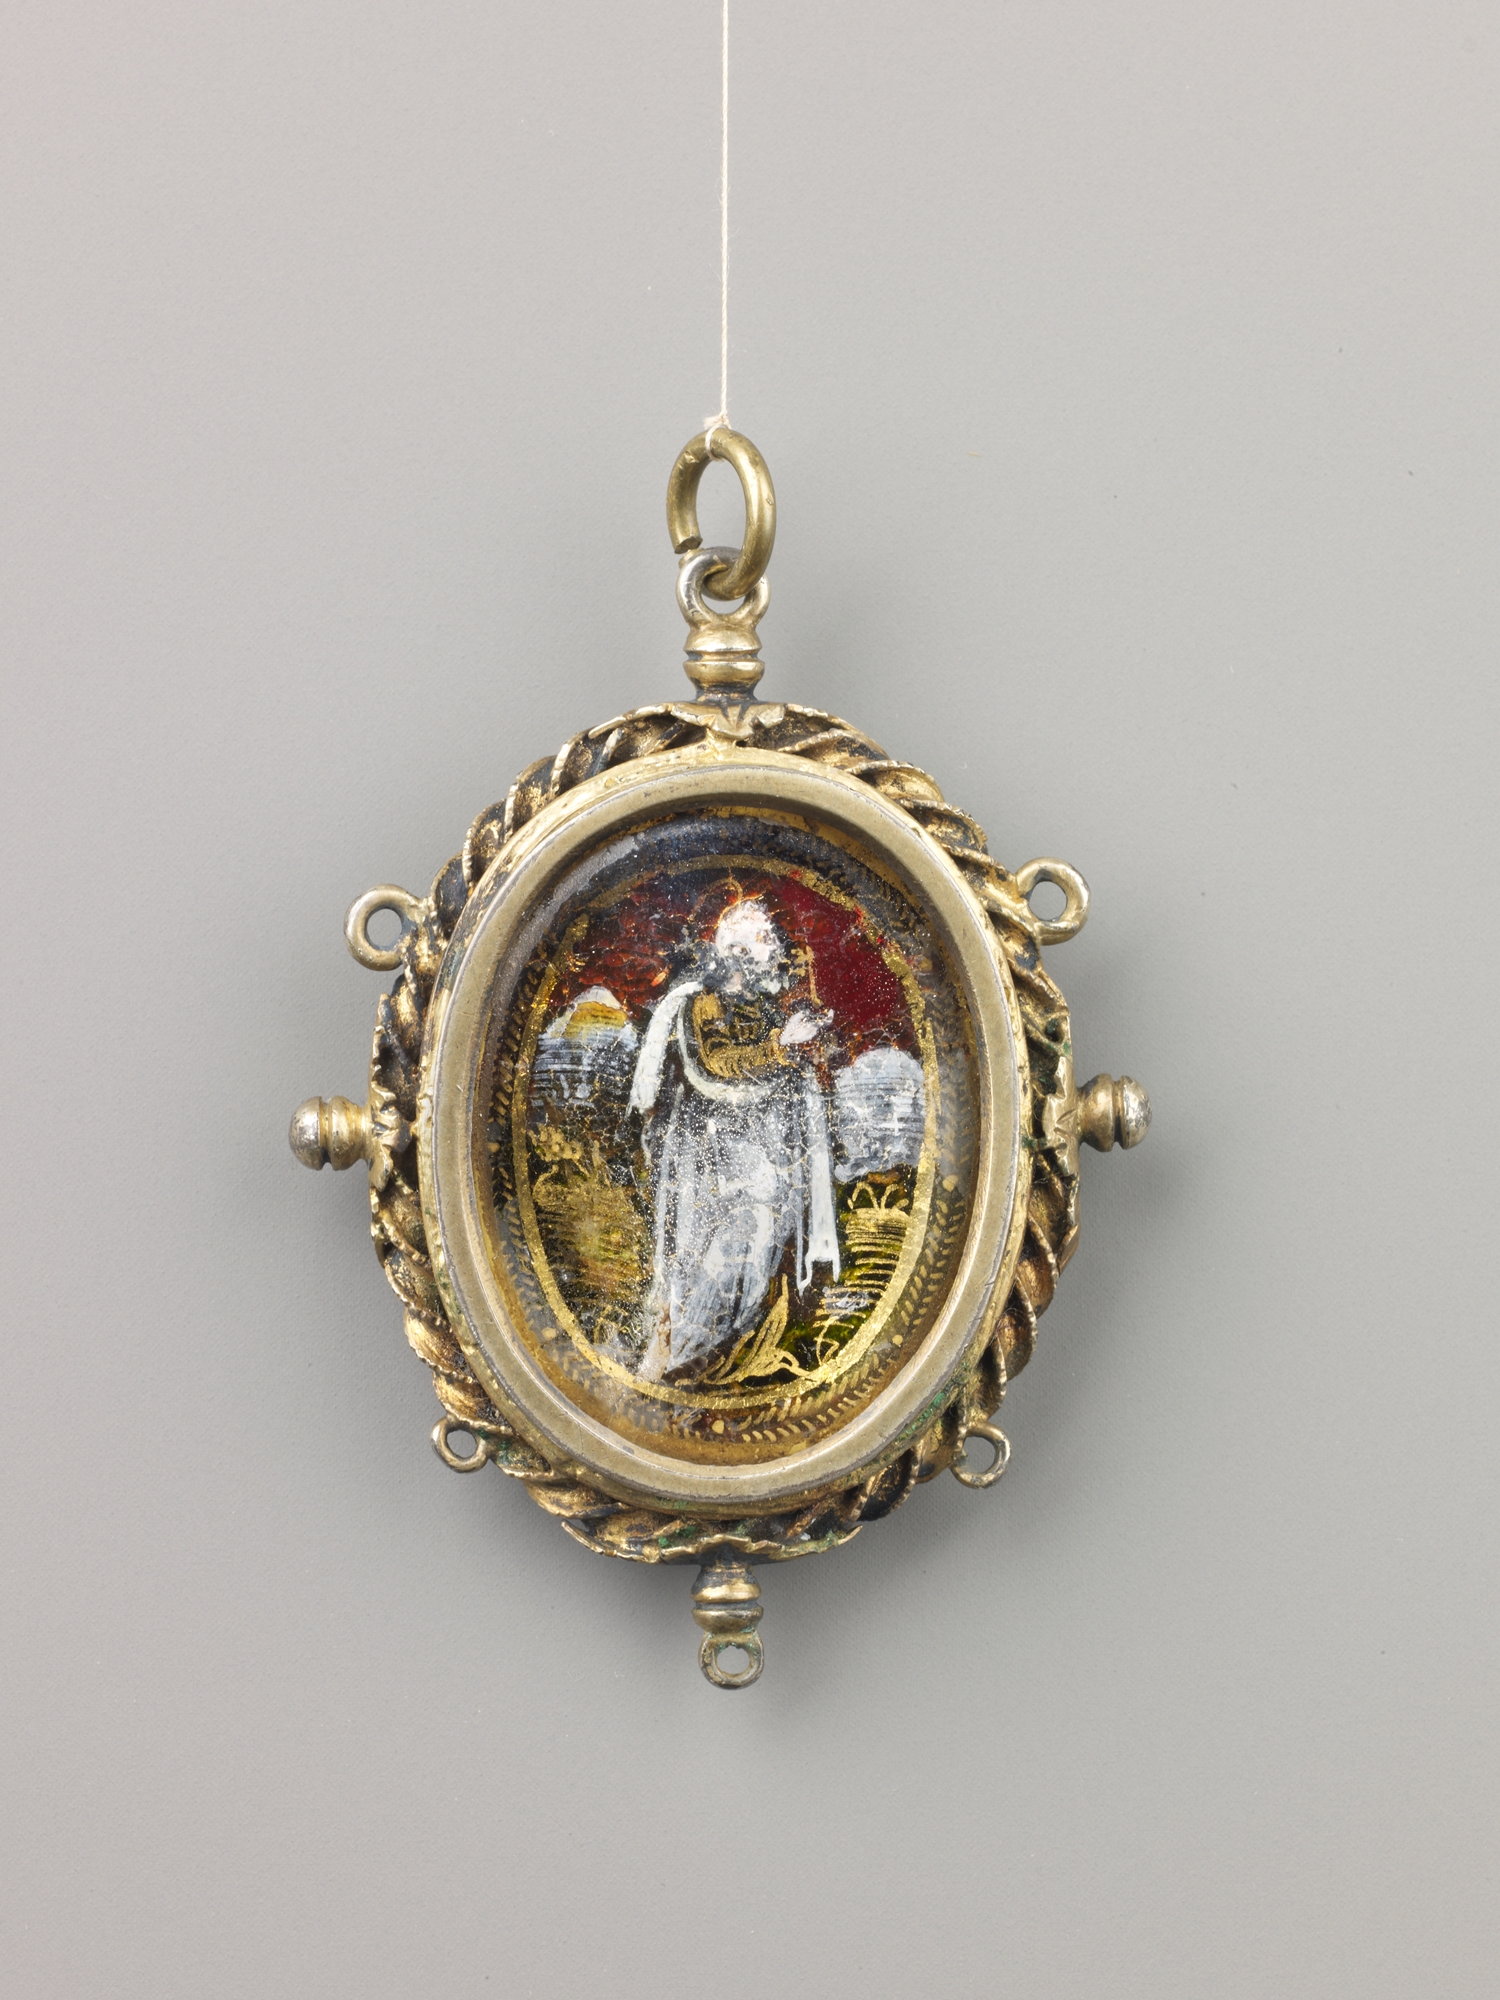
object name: pendant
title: Devotional pendant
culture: spanish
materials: gilt, quartz, silver gilt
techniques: cutting, painting, polish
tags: men